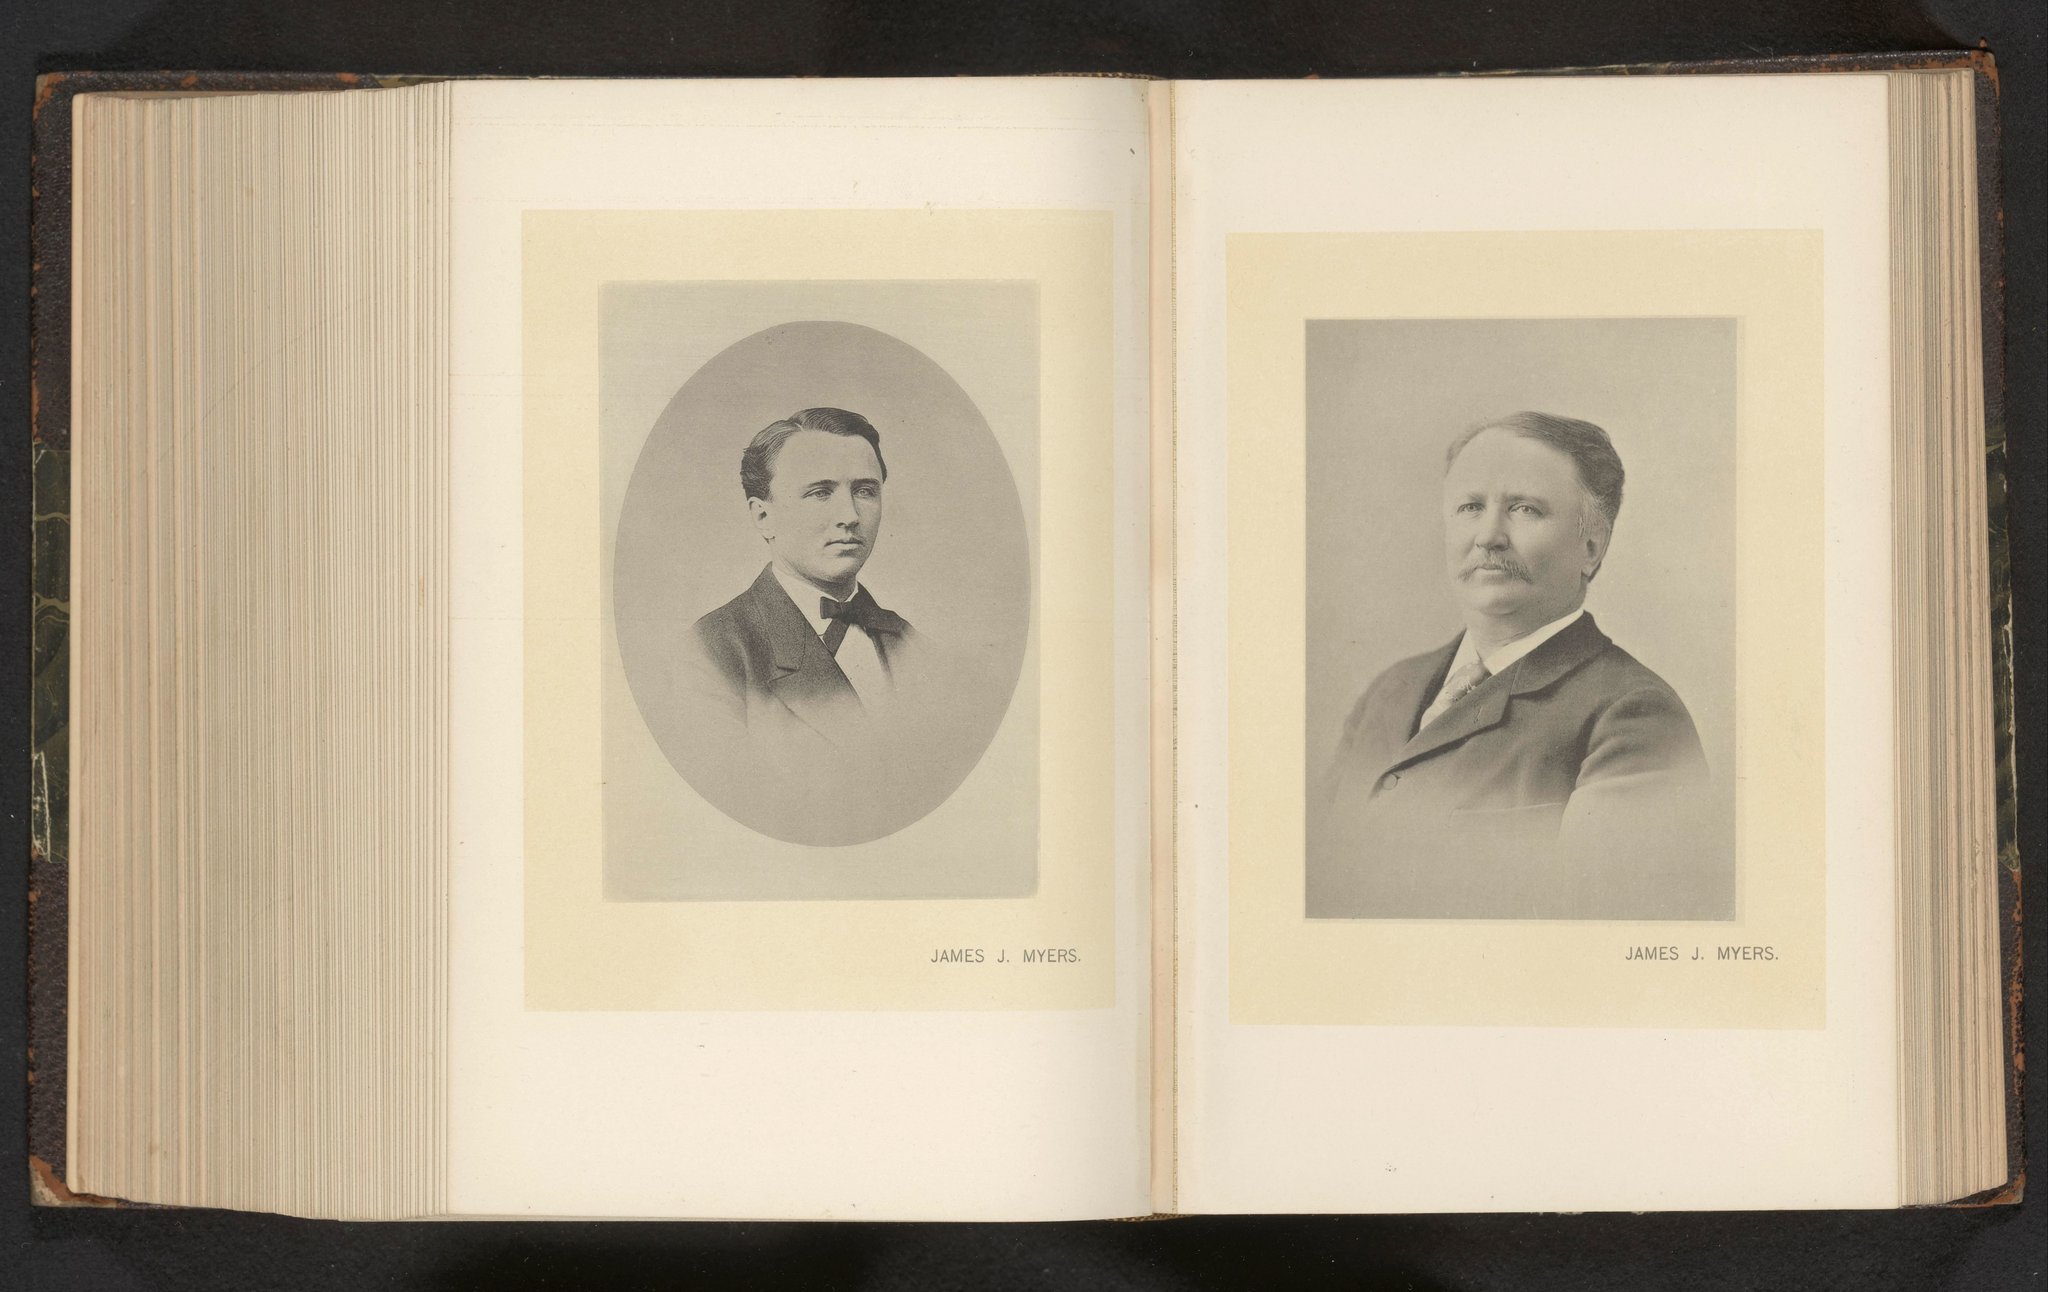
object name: page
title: James J. Myers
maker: Anonymous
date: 1889-1894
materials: paper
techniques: photoaquatint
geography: boston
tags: lawyer, attorney at law